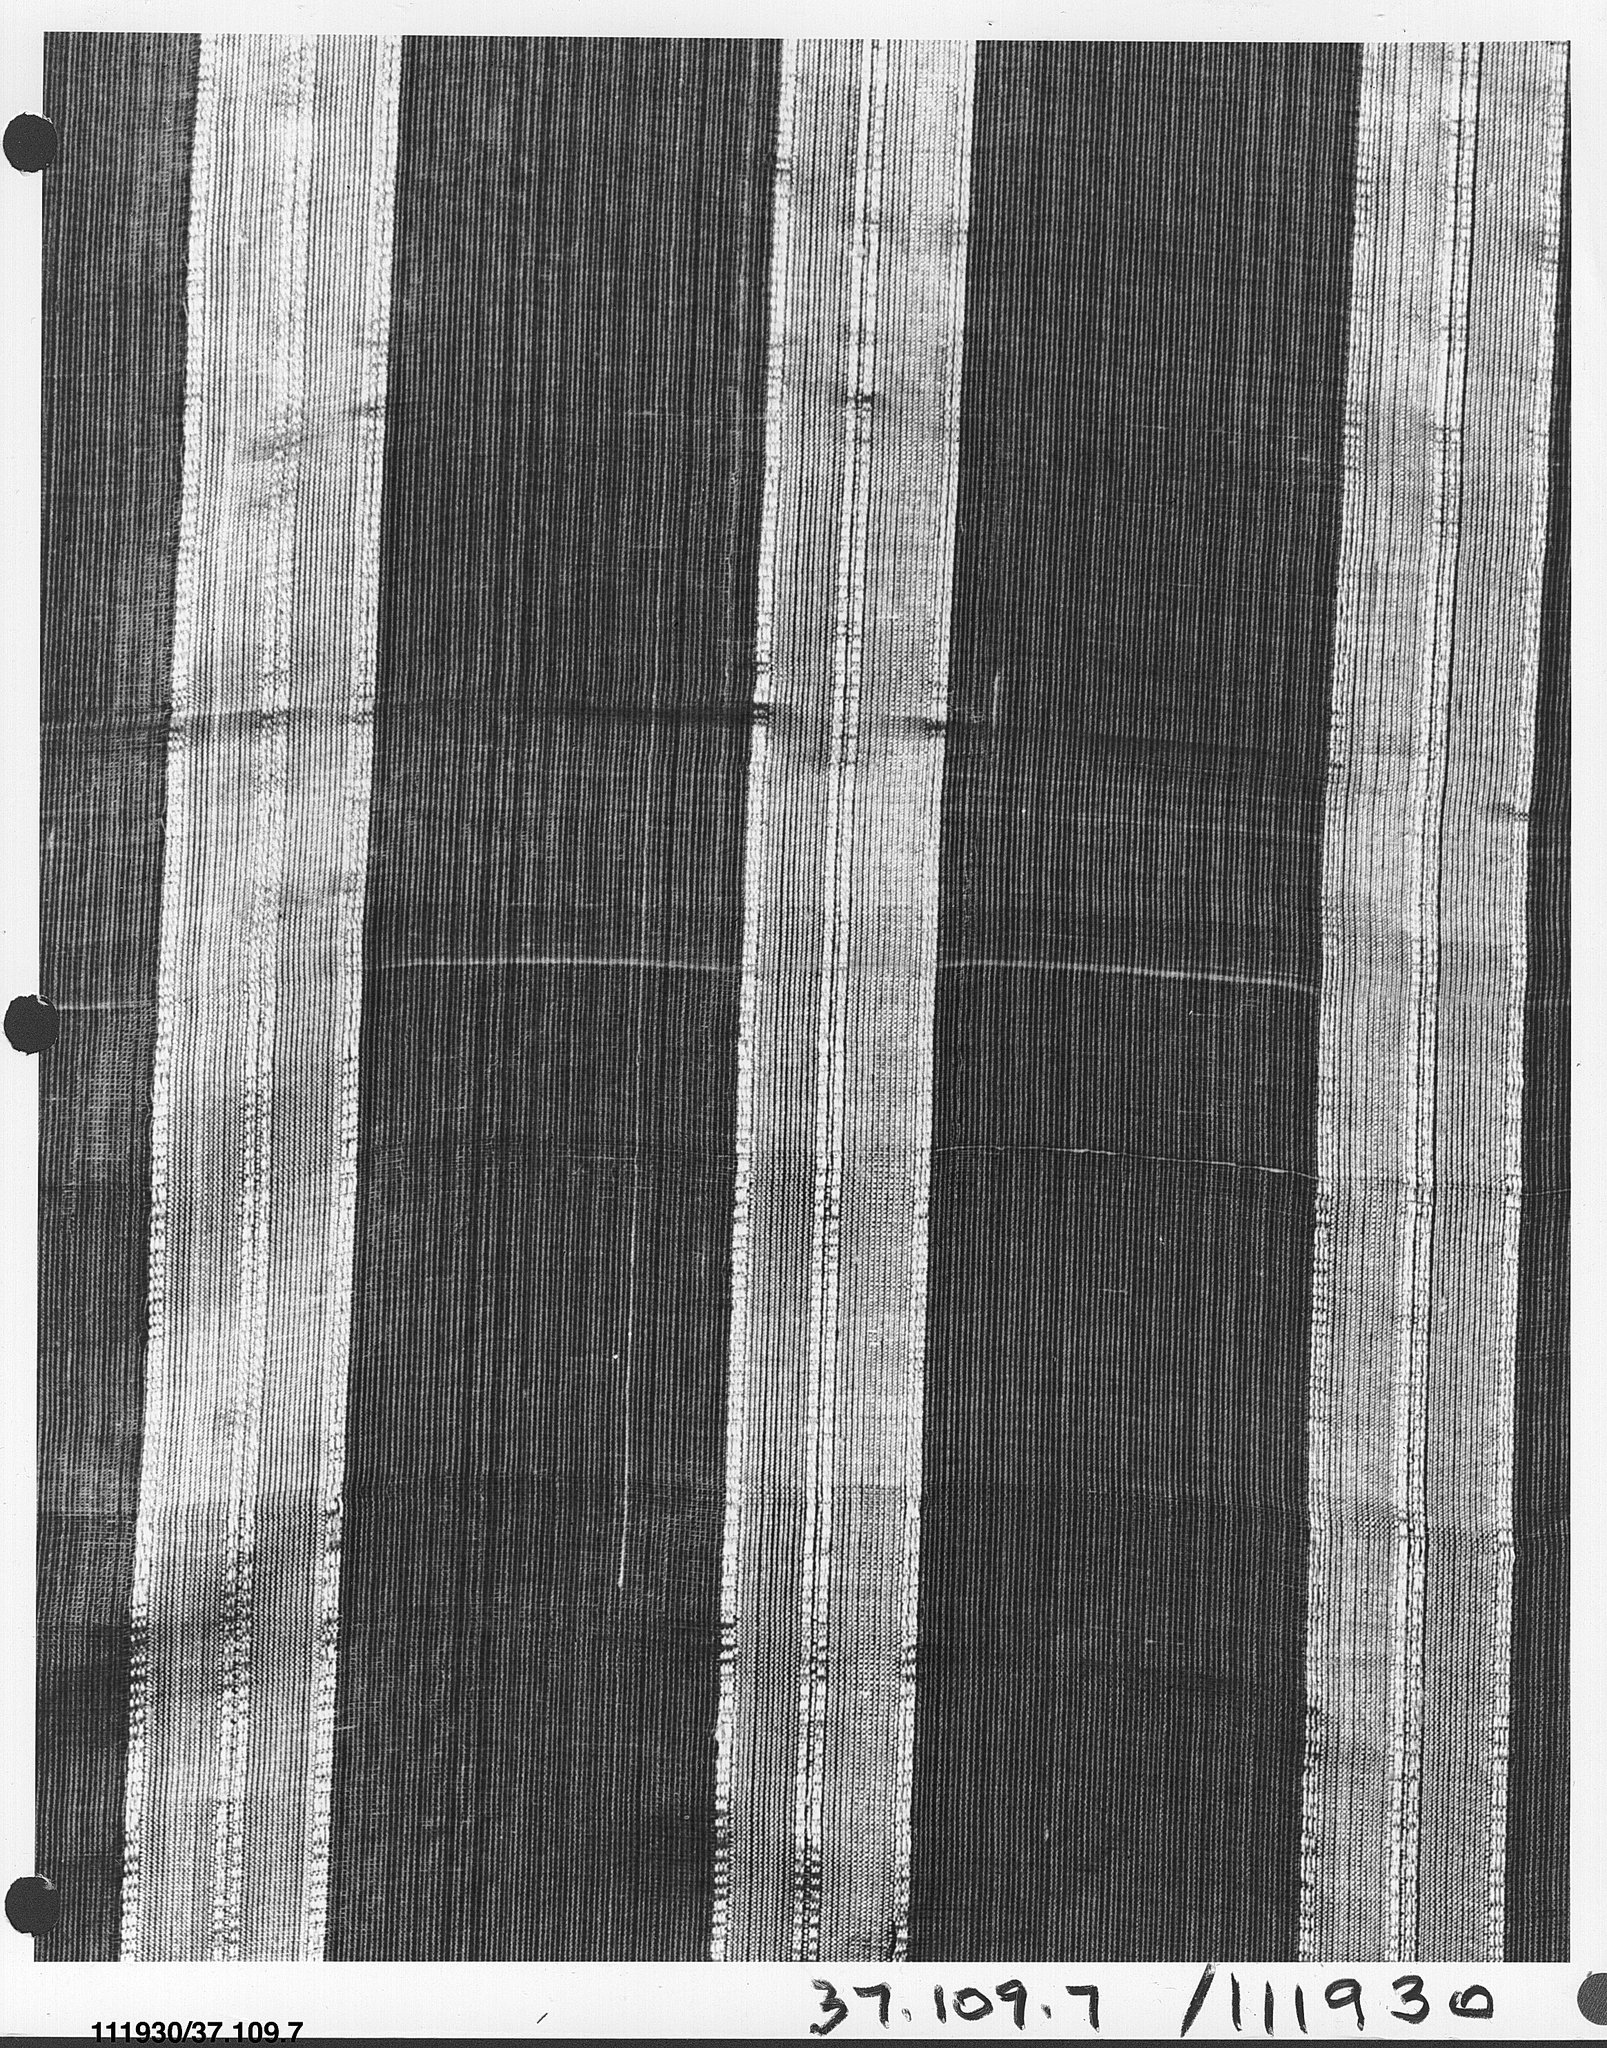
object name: piece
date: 1801-1900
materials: fiber, silk